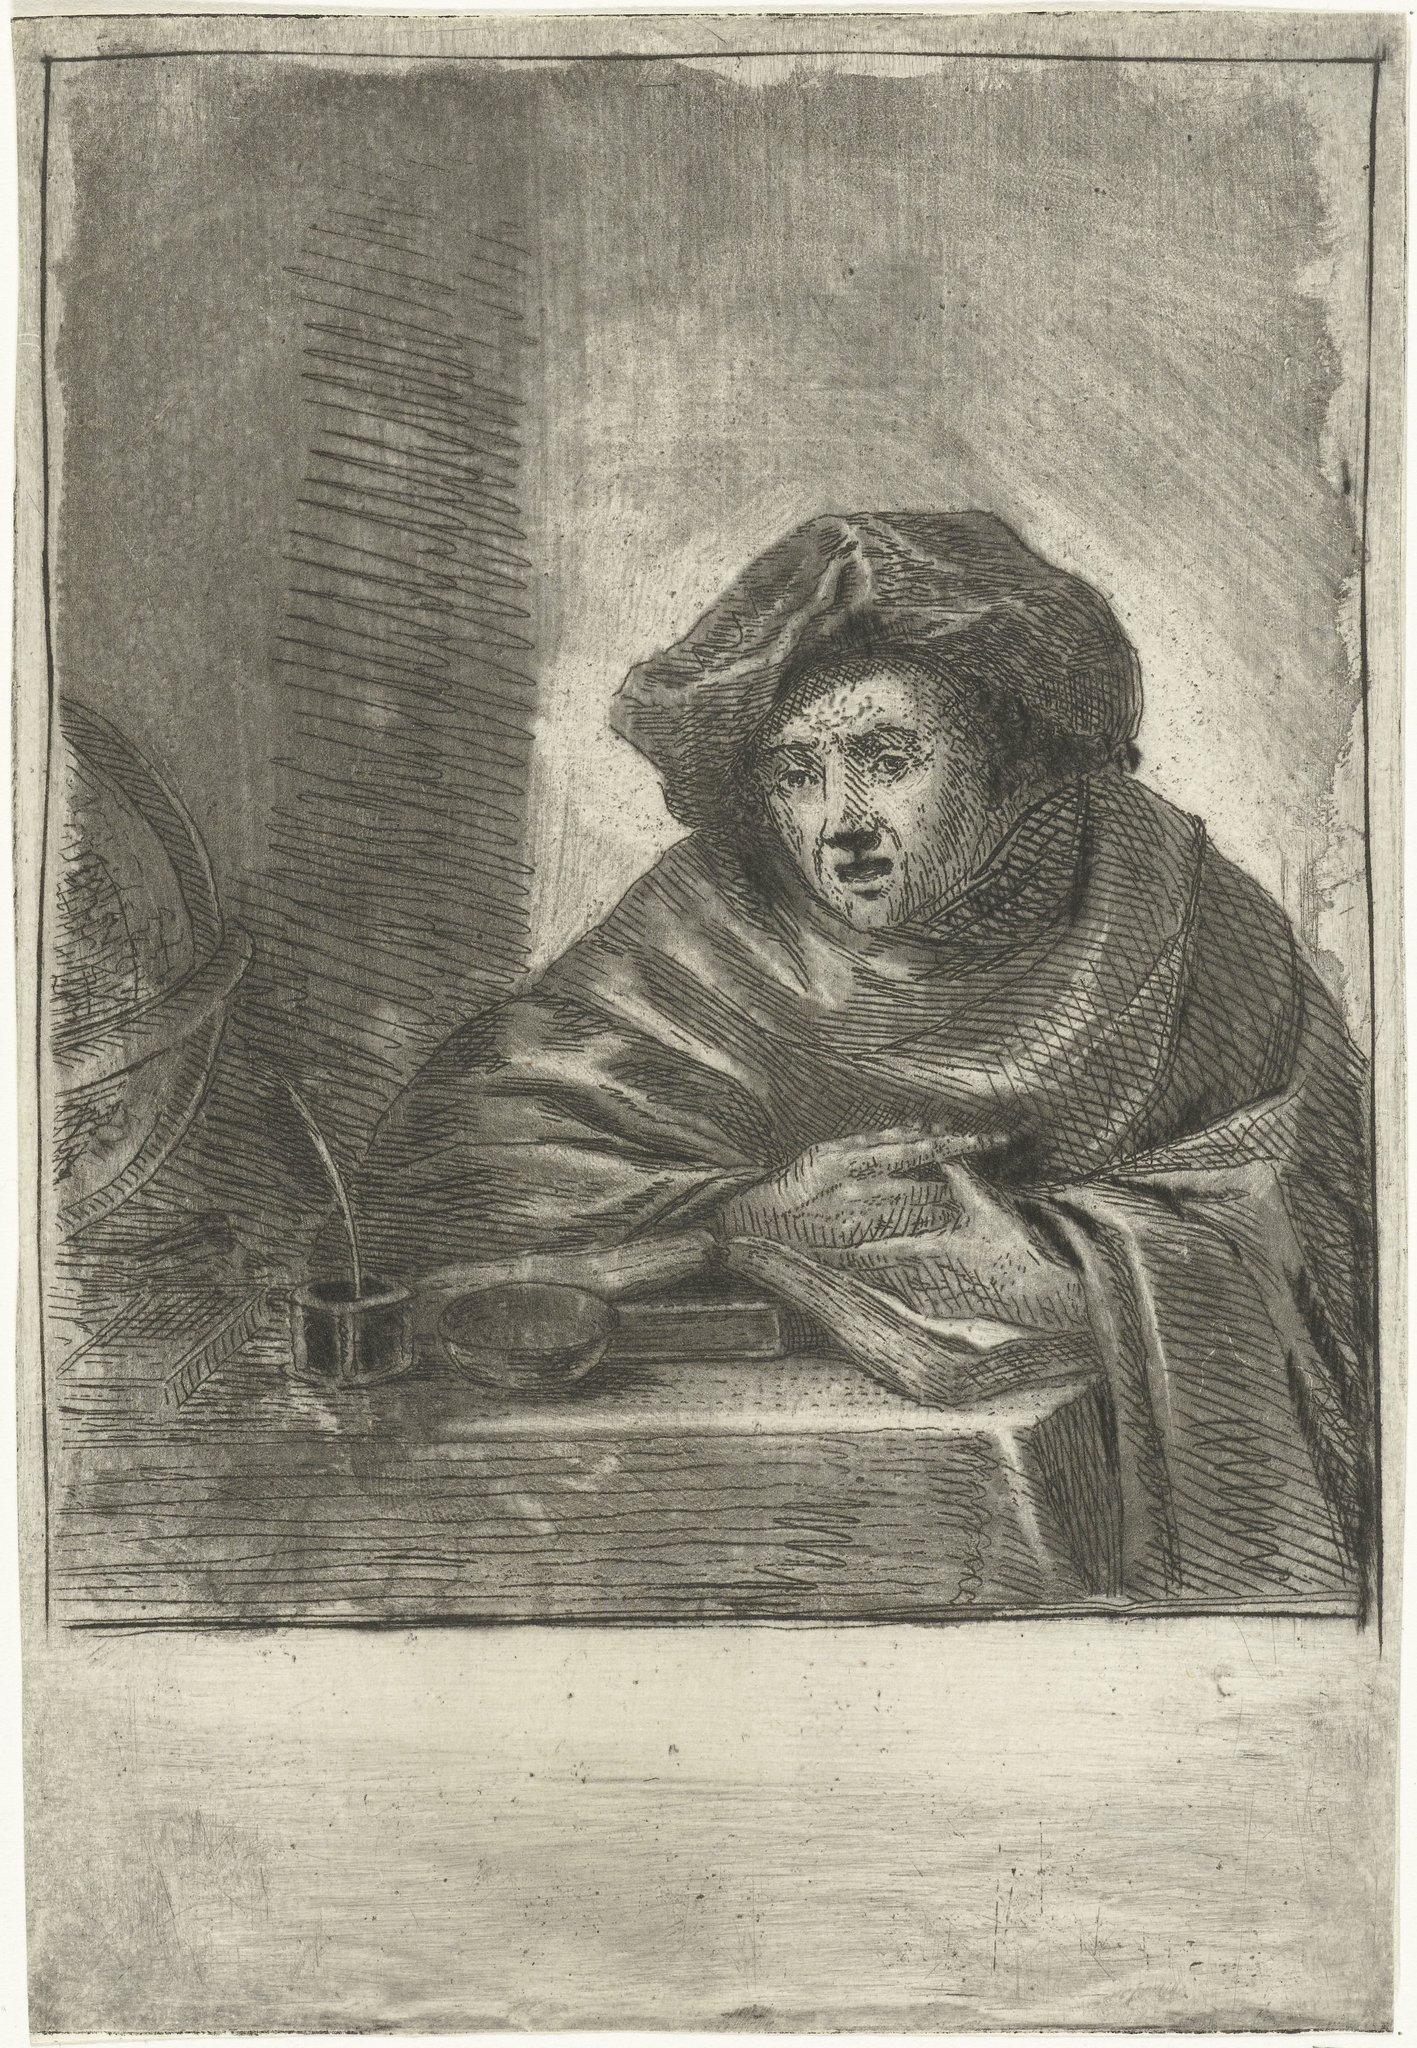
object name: print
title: Geleerde in zijn werkkamer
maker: louis bernard coclers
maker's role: draughtsman, print maker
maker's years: 1741-1817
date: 1756-1817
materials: paper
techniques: aquatint, drypoint, etching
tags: scholar in his study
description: Een wetenschapper zit aan zijn bureau. Op tafel een globe, boeken en een inktpot met een schrijfveer.